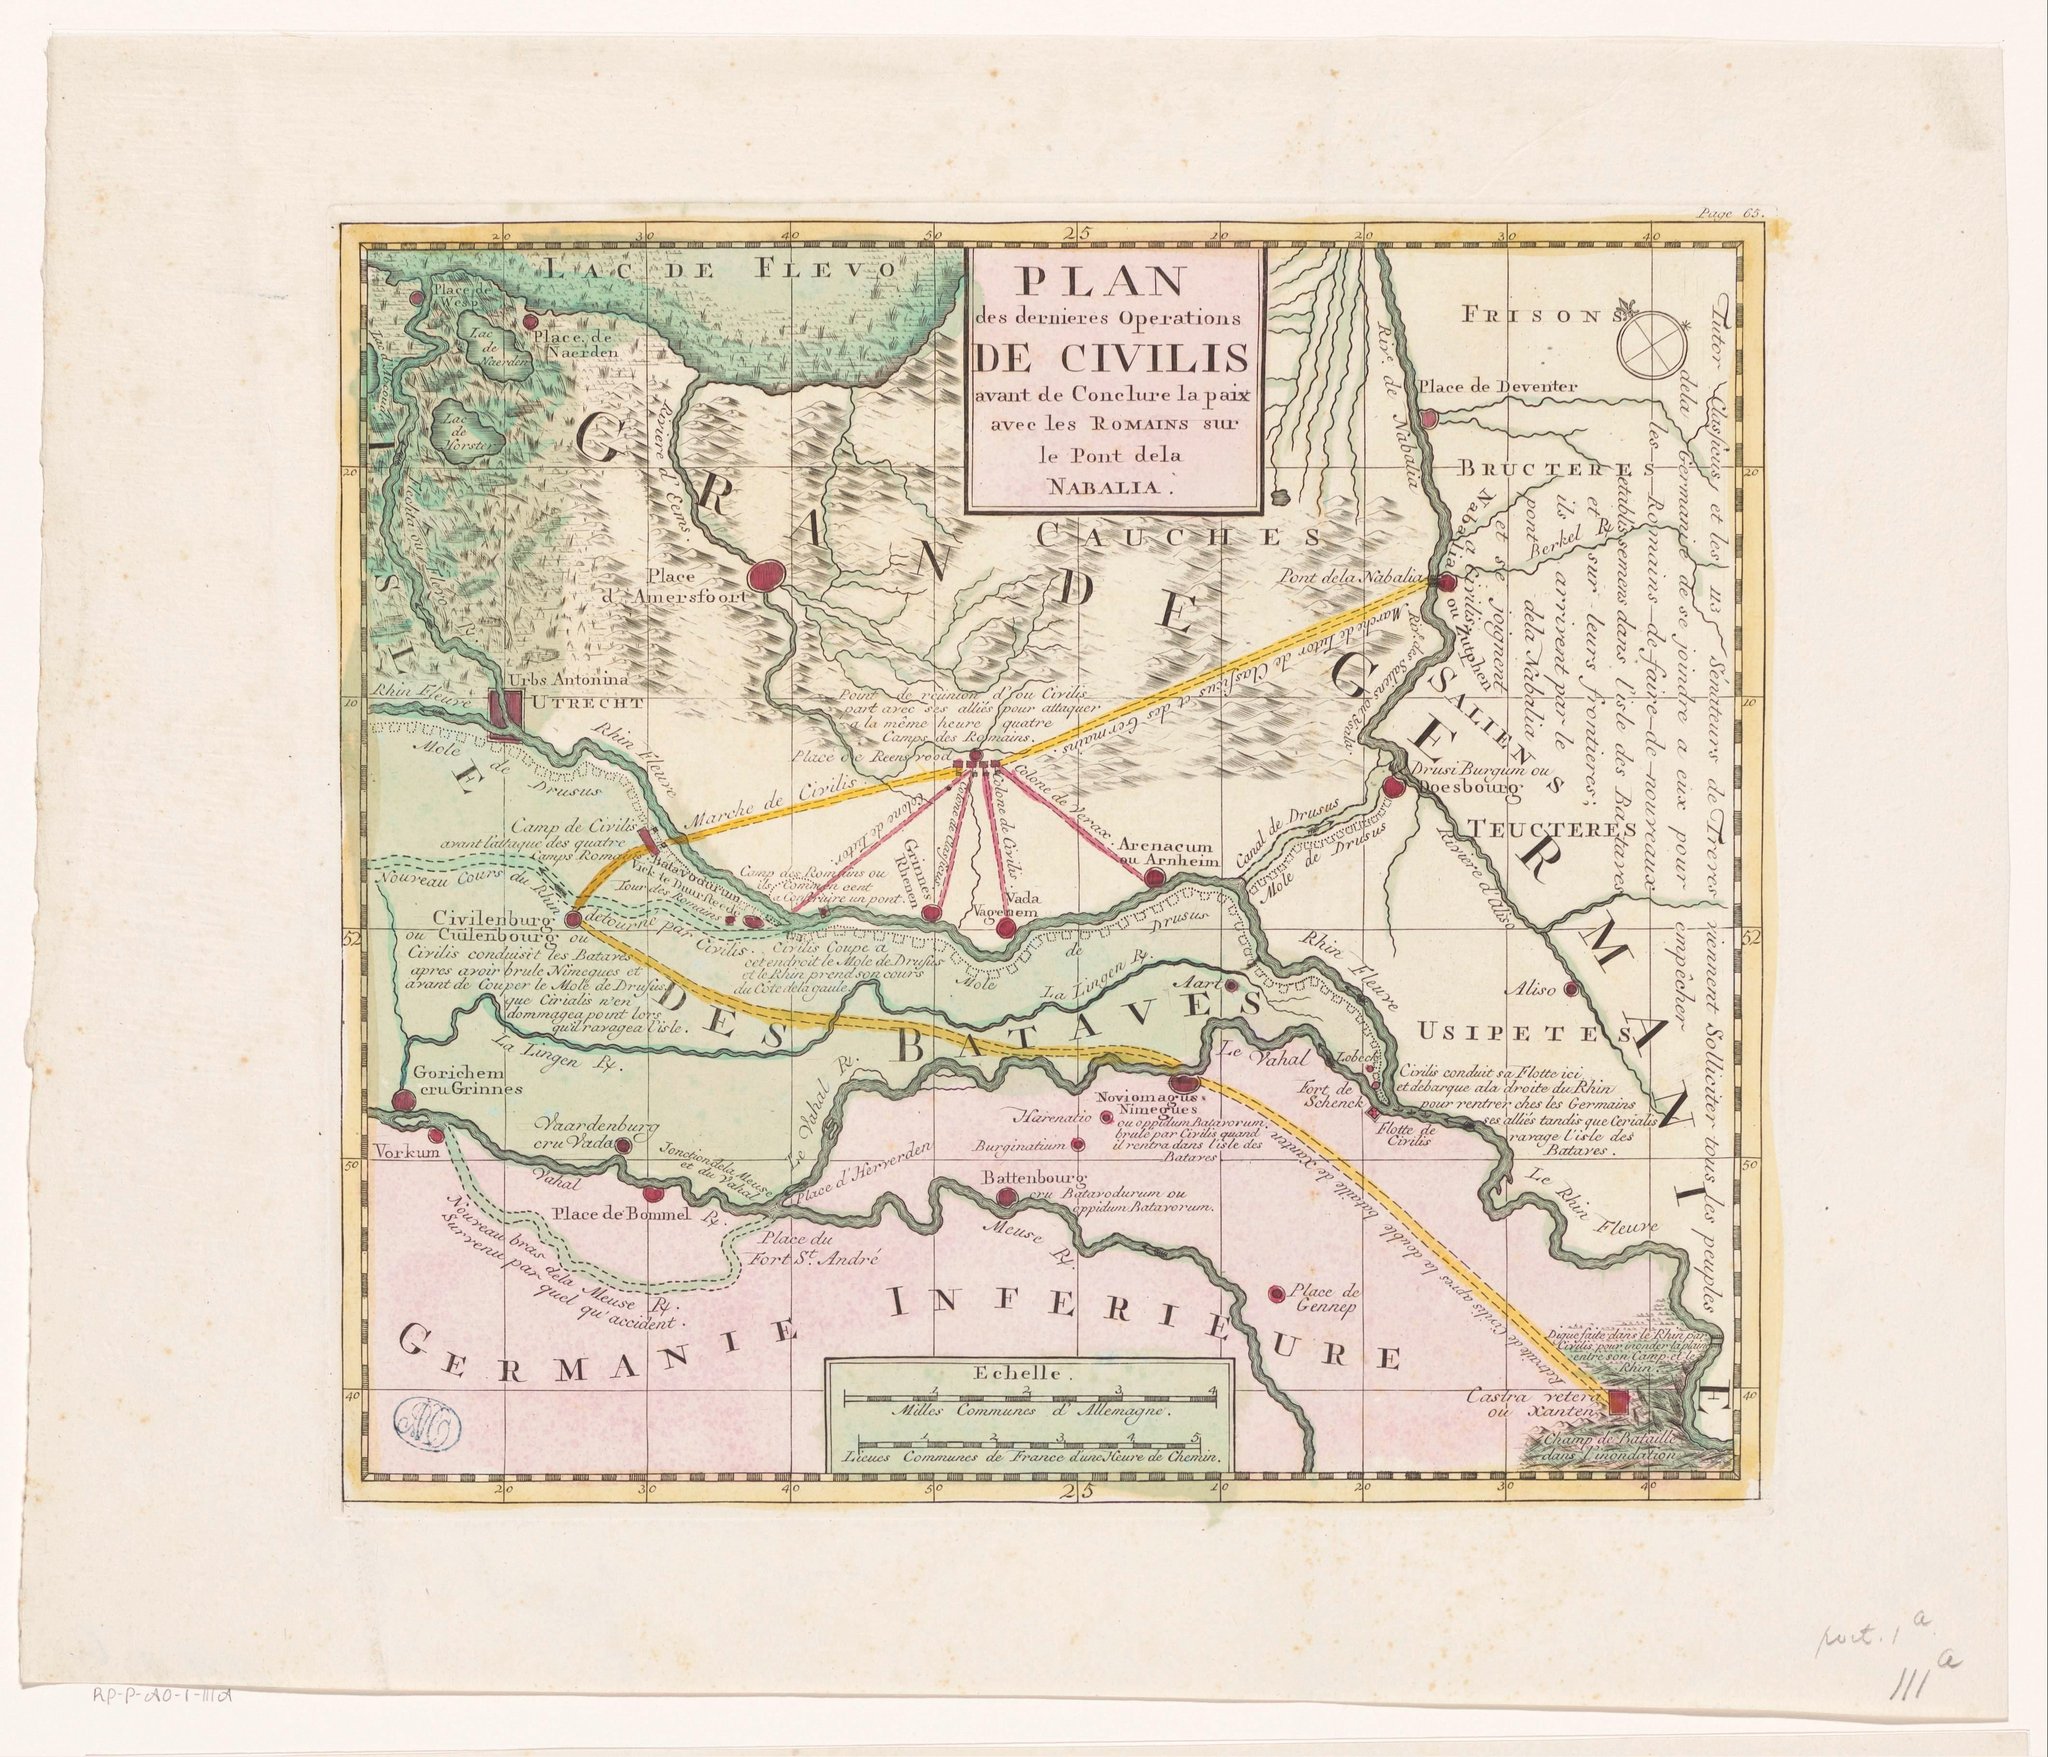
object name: map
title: Plan des dernieres operations de civilis avant de conclure la paix avec les Romains sur le pont dela Nabalia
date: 1770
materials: paper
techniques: engraving, etching, hand coloring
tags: maps of separate countries or regions, netherlands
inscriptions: collector's mark: Lugt 2228, collector's mark: Lugt 195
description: Deze kaart behoort tot een serie prenten over de Bataafse Opstand, gekopieerd naar de reeks Batavorum cum Romanis bellum van Antonio Tempesta (Otto Vaenius, Antwerpen 1612) en gebruikt in: Saint-Simon, Maximilien Henri marquis de. Histoire de la guerre des Bataves et des Romains, d'après César, Corneille Tacite &c. Amsterdam: Marc Michel Rey, 1770. Deze kaart is in die publicatie te vinden op p. 65.